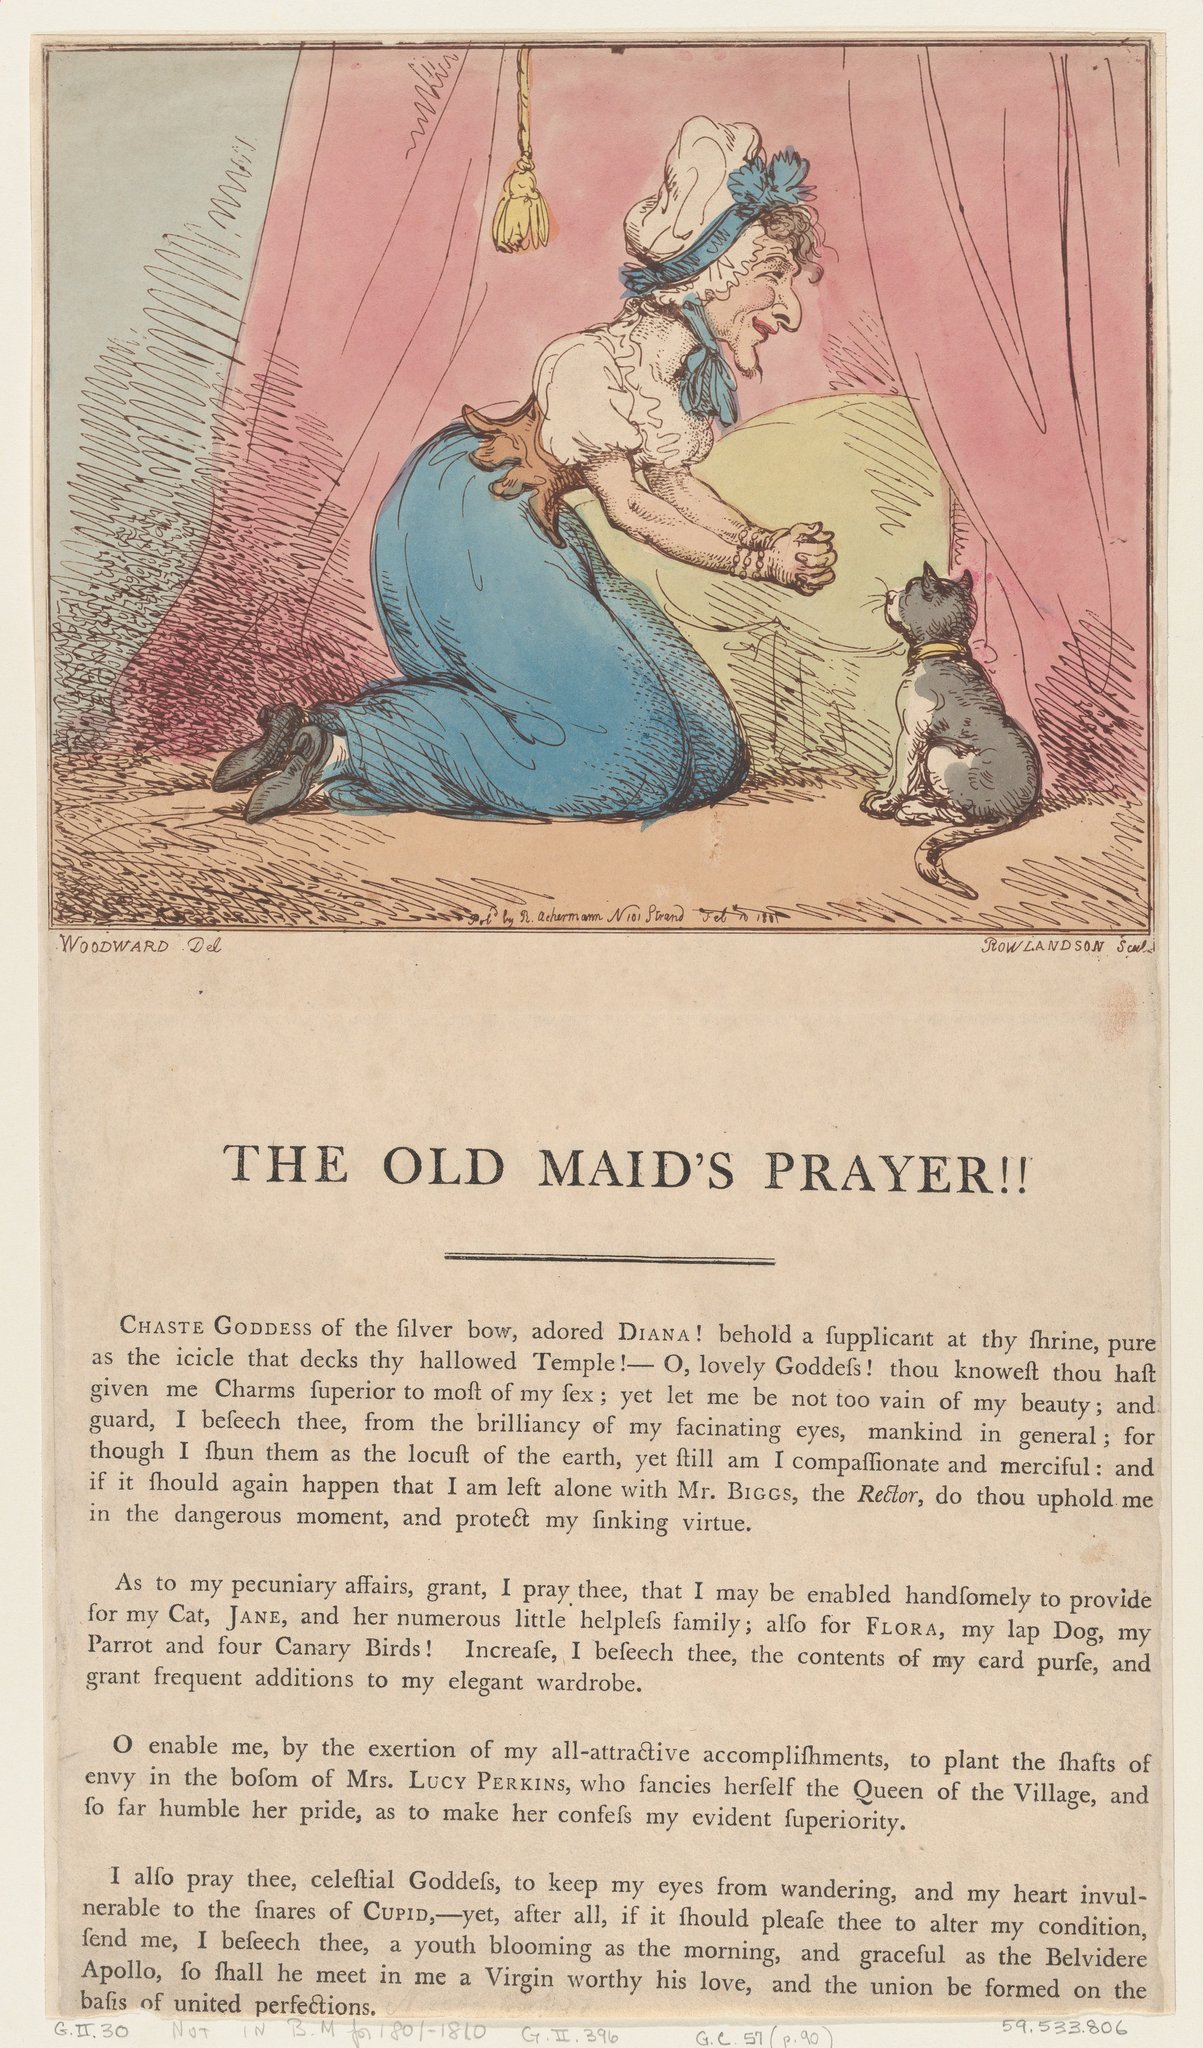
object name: print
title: The Old Maid's Prayer!!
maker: thomas rowlandson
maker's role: artist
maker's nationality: british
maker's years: 1757-1827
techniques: etching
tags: satire,women,cats